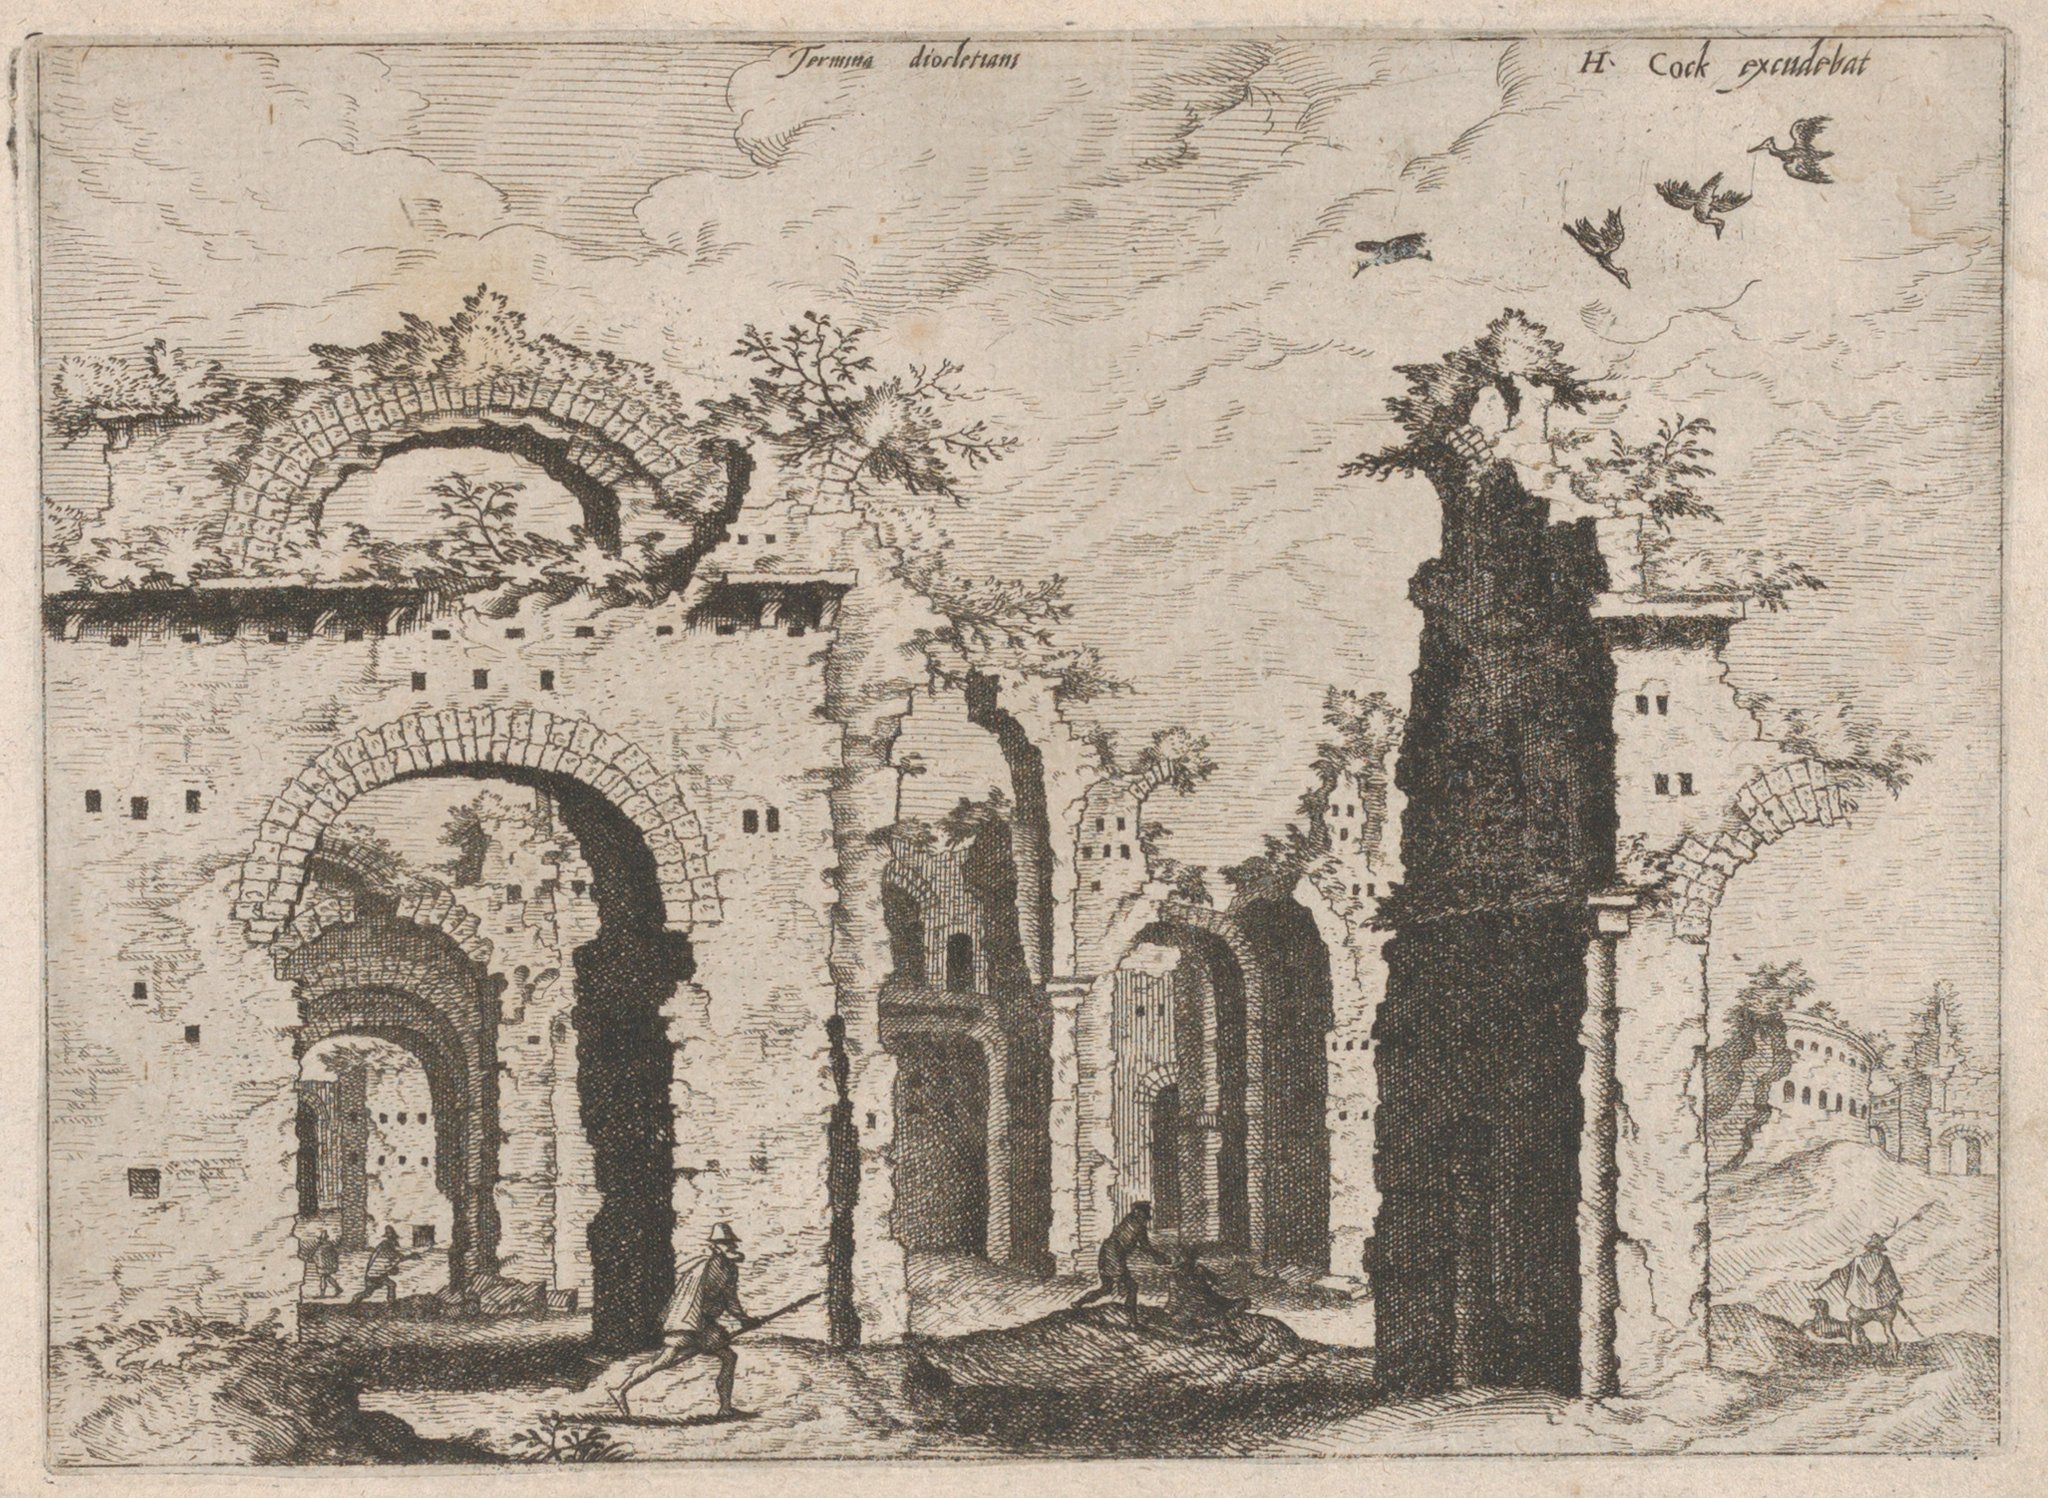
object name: print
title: The Baths of Diocletian, from "Roman Ruins and Buildings"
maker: johannes van doetecum i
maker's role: artist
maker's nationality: netherlandish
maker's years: 1528-1605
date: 1562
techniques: etching